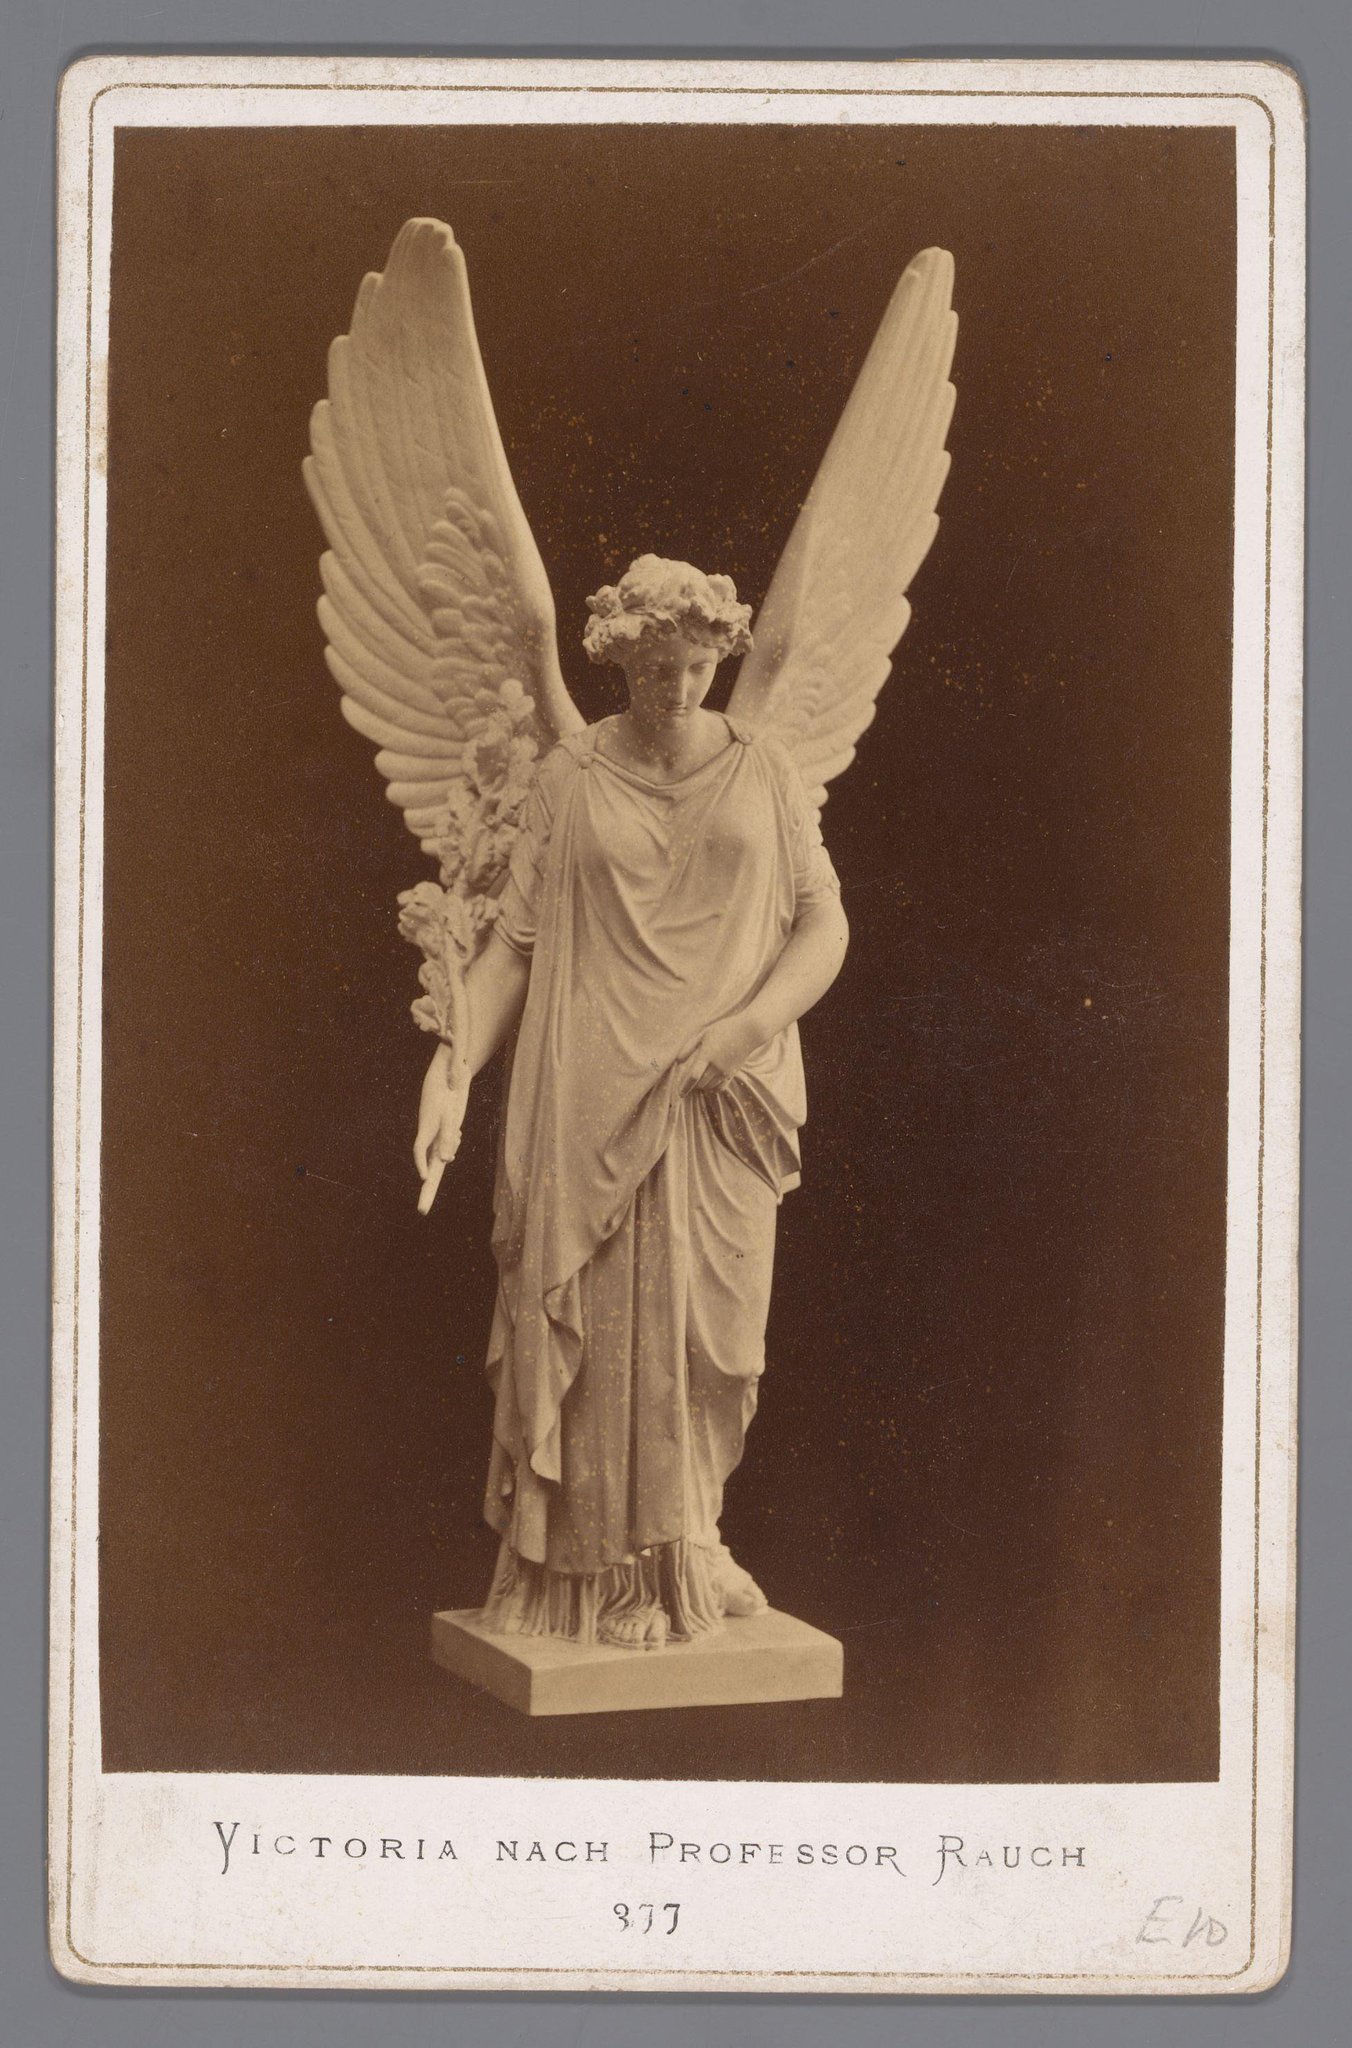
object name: photograph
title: Sculptuur van Victoria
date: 1851-1900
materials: cardboard, paper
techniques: albumen print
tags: victoria as roman personification, piece of sculpture, reproduction of a piece of sculpture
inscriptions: inscription: ‘E10’, number: ‘377’